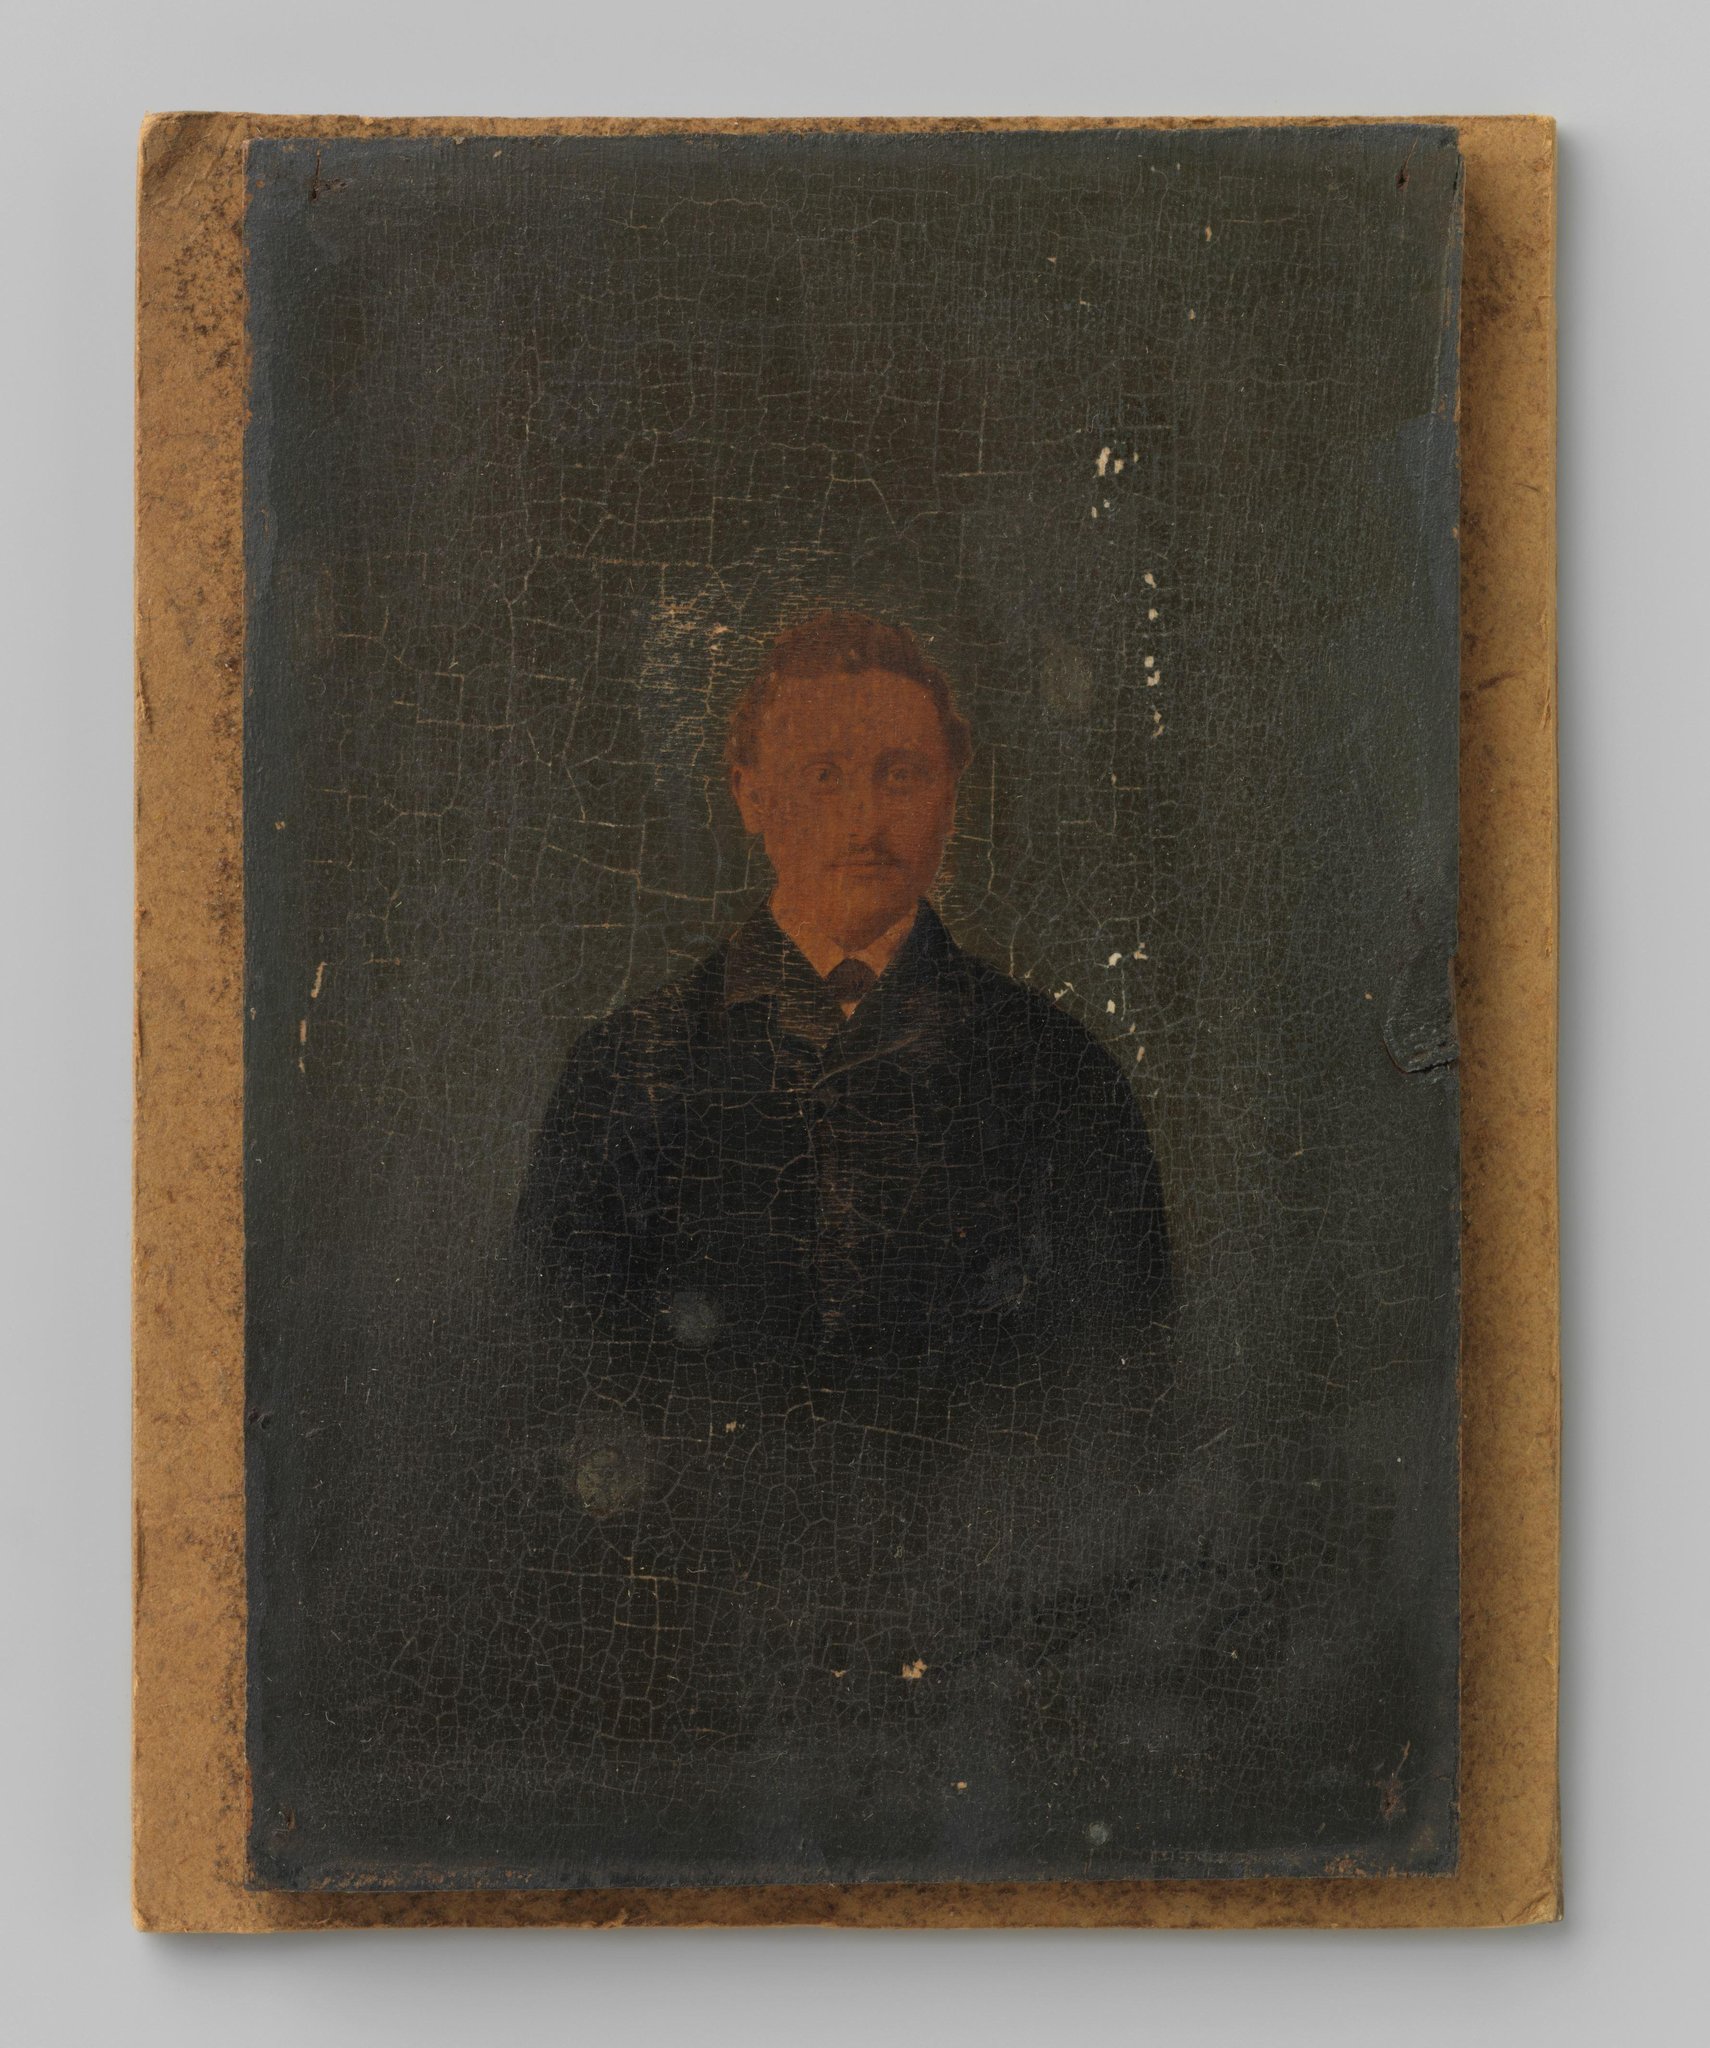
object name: photograph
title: Portret van een onbekende man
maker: Anonymous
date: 1880-1900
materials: cardboard, paint, paper, wood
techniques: albumen print, hand coloring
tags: adult man, anonymous historical person portrayed